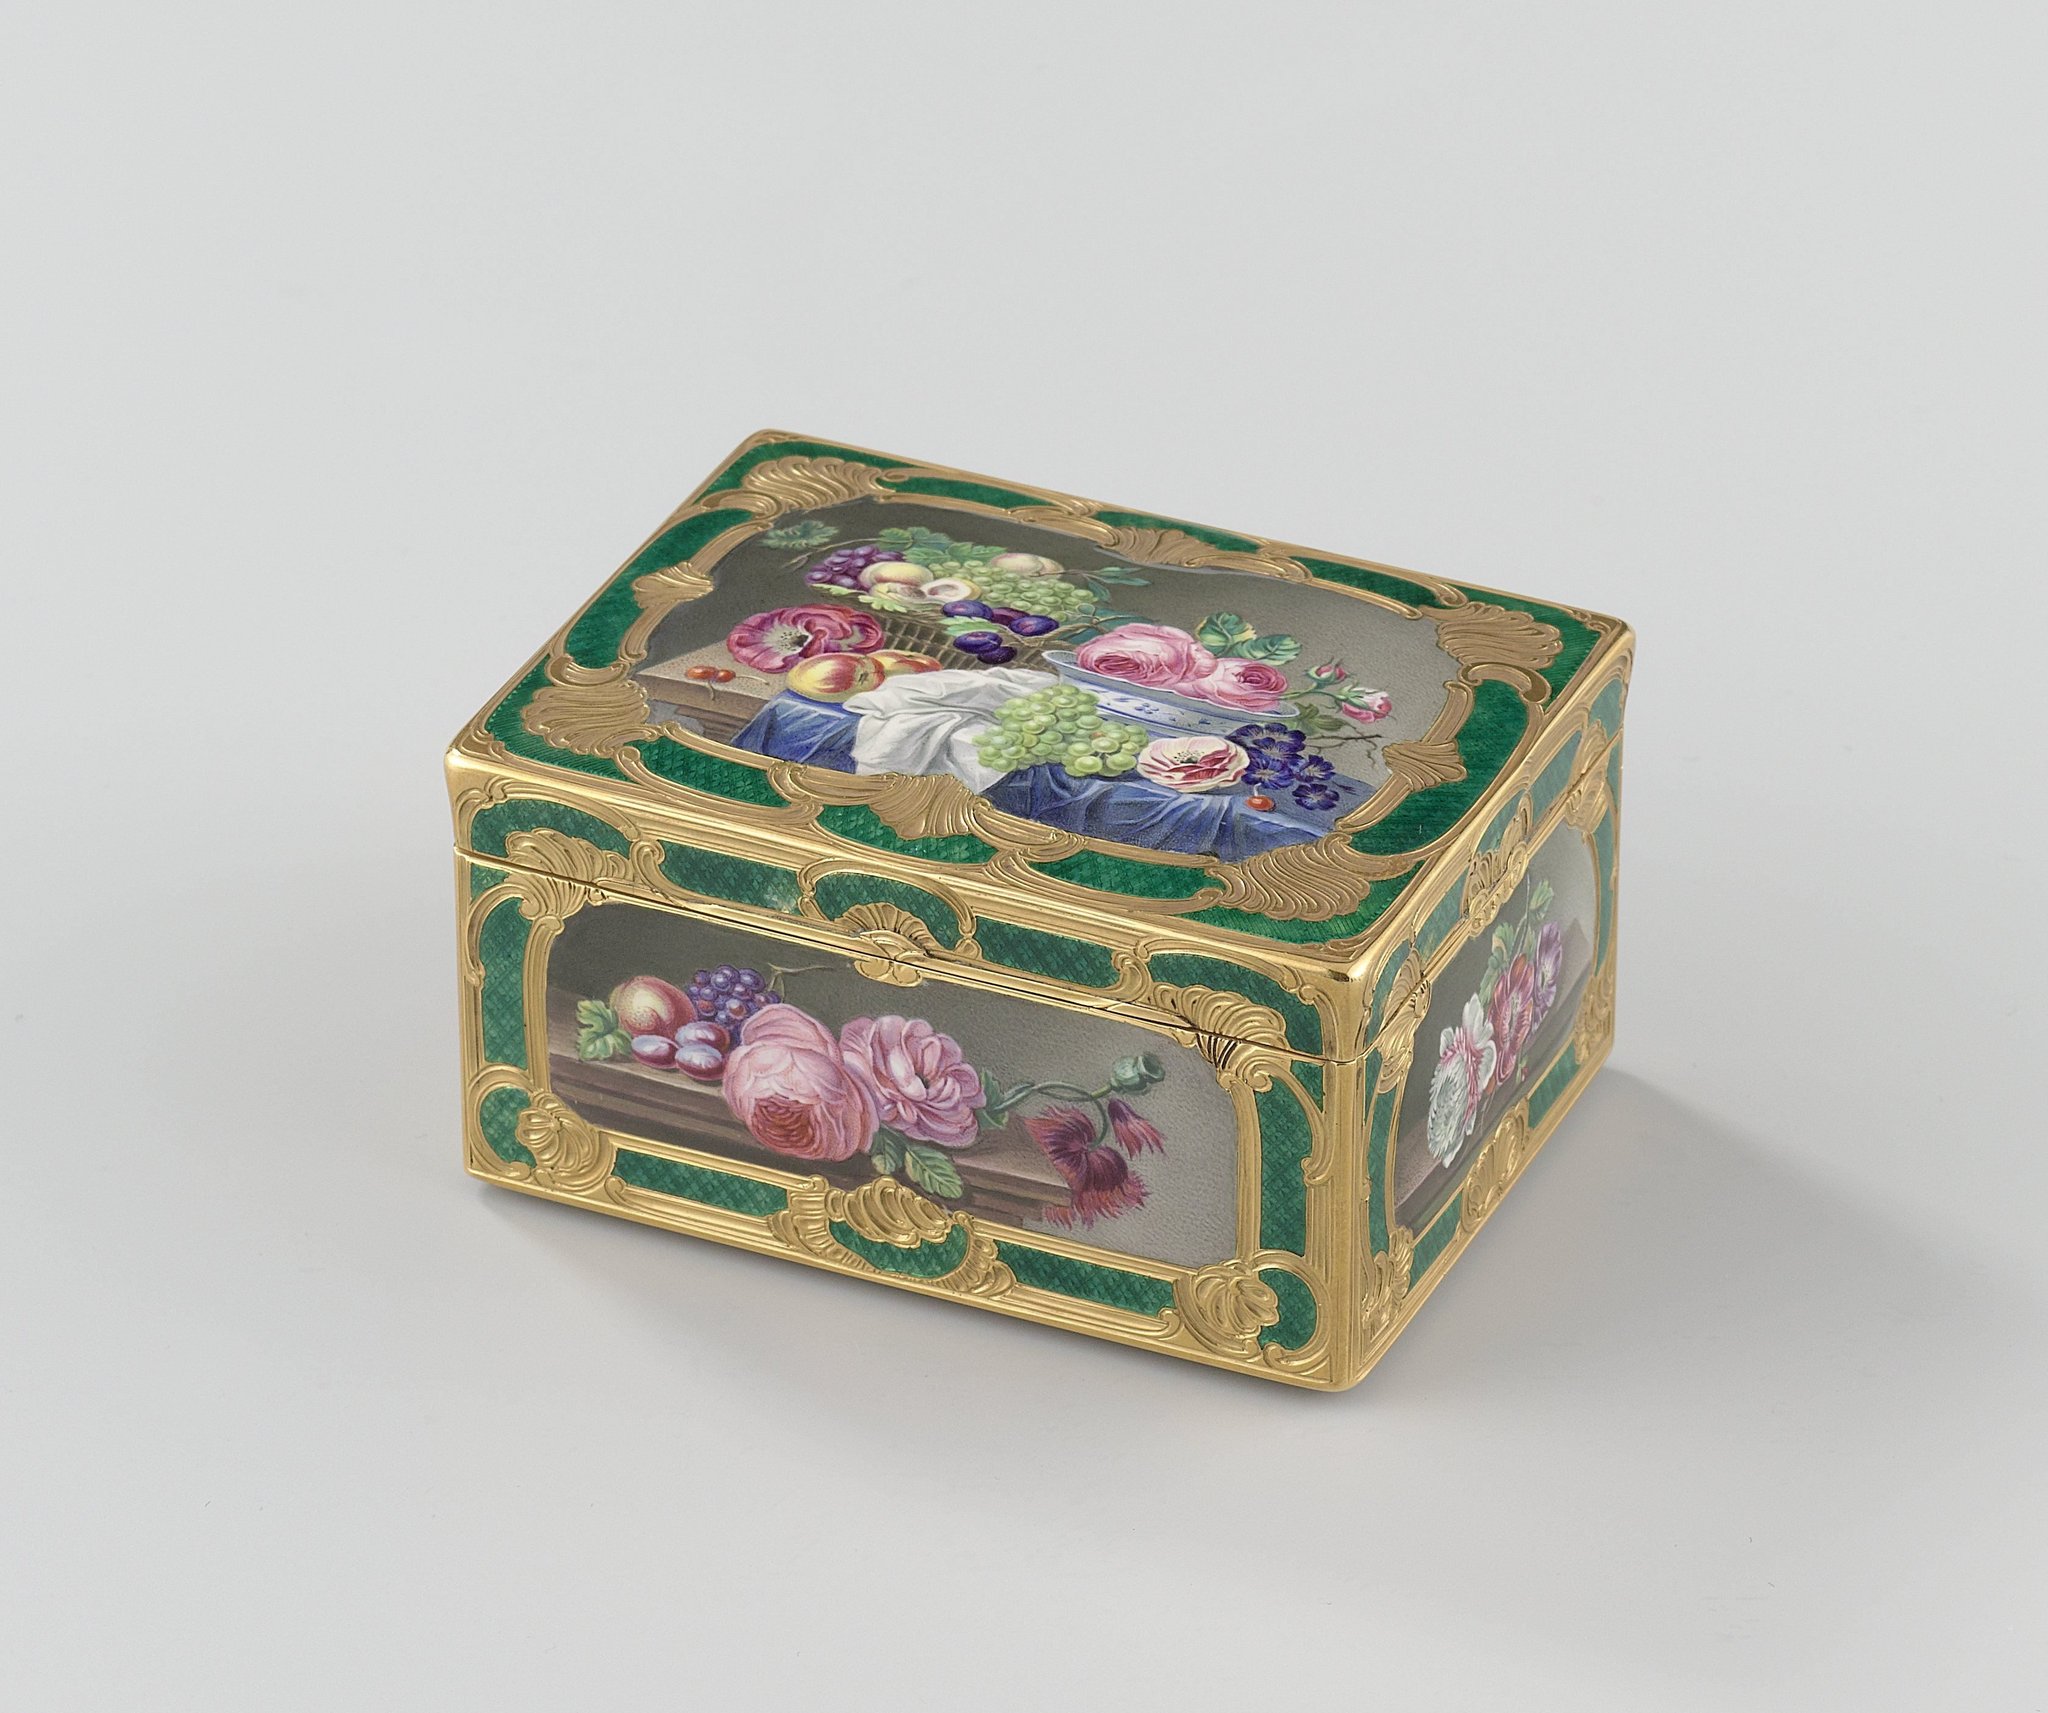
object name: box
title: Snuifdoos van goud, rechthoekig, versierd met bloemen- en vruchtenslingers in émail binnen een rand van felgroene vakken in rocaille-omlijsting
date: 1800-1900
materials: gold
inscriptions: date letter (false), maker's mark (false), duty mark (false)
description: Bottle. Gold, enamel. Paris, c. 1760. Snuffbox. Gold, enamel. Paris, 1772 - 1773, by Charles-Barnabé Sageret.